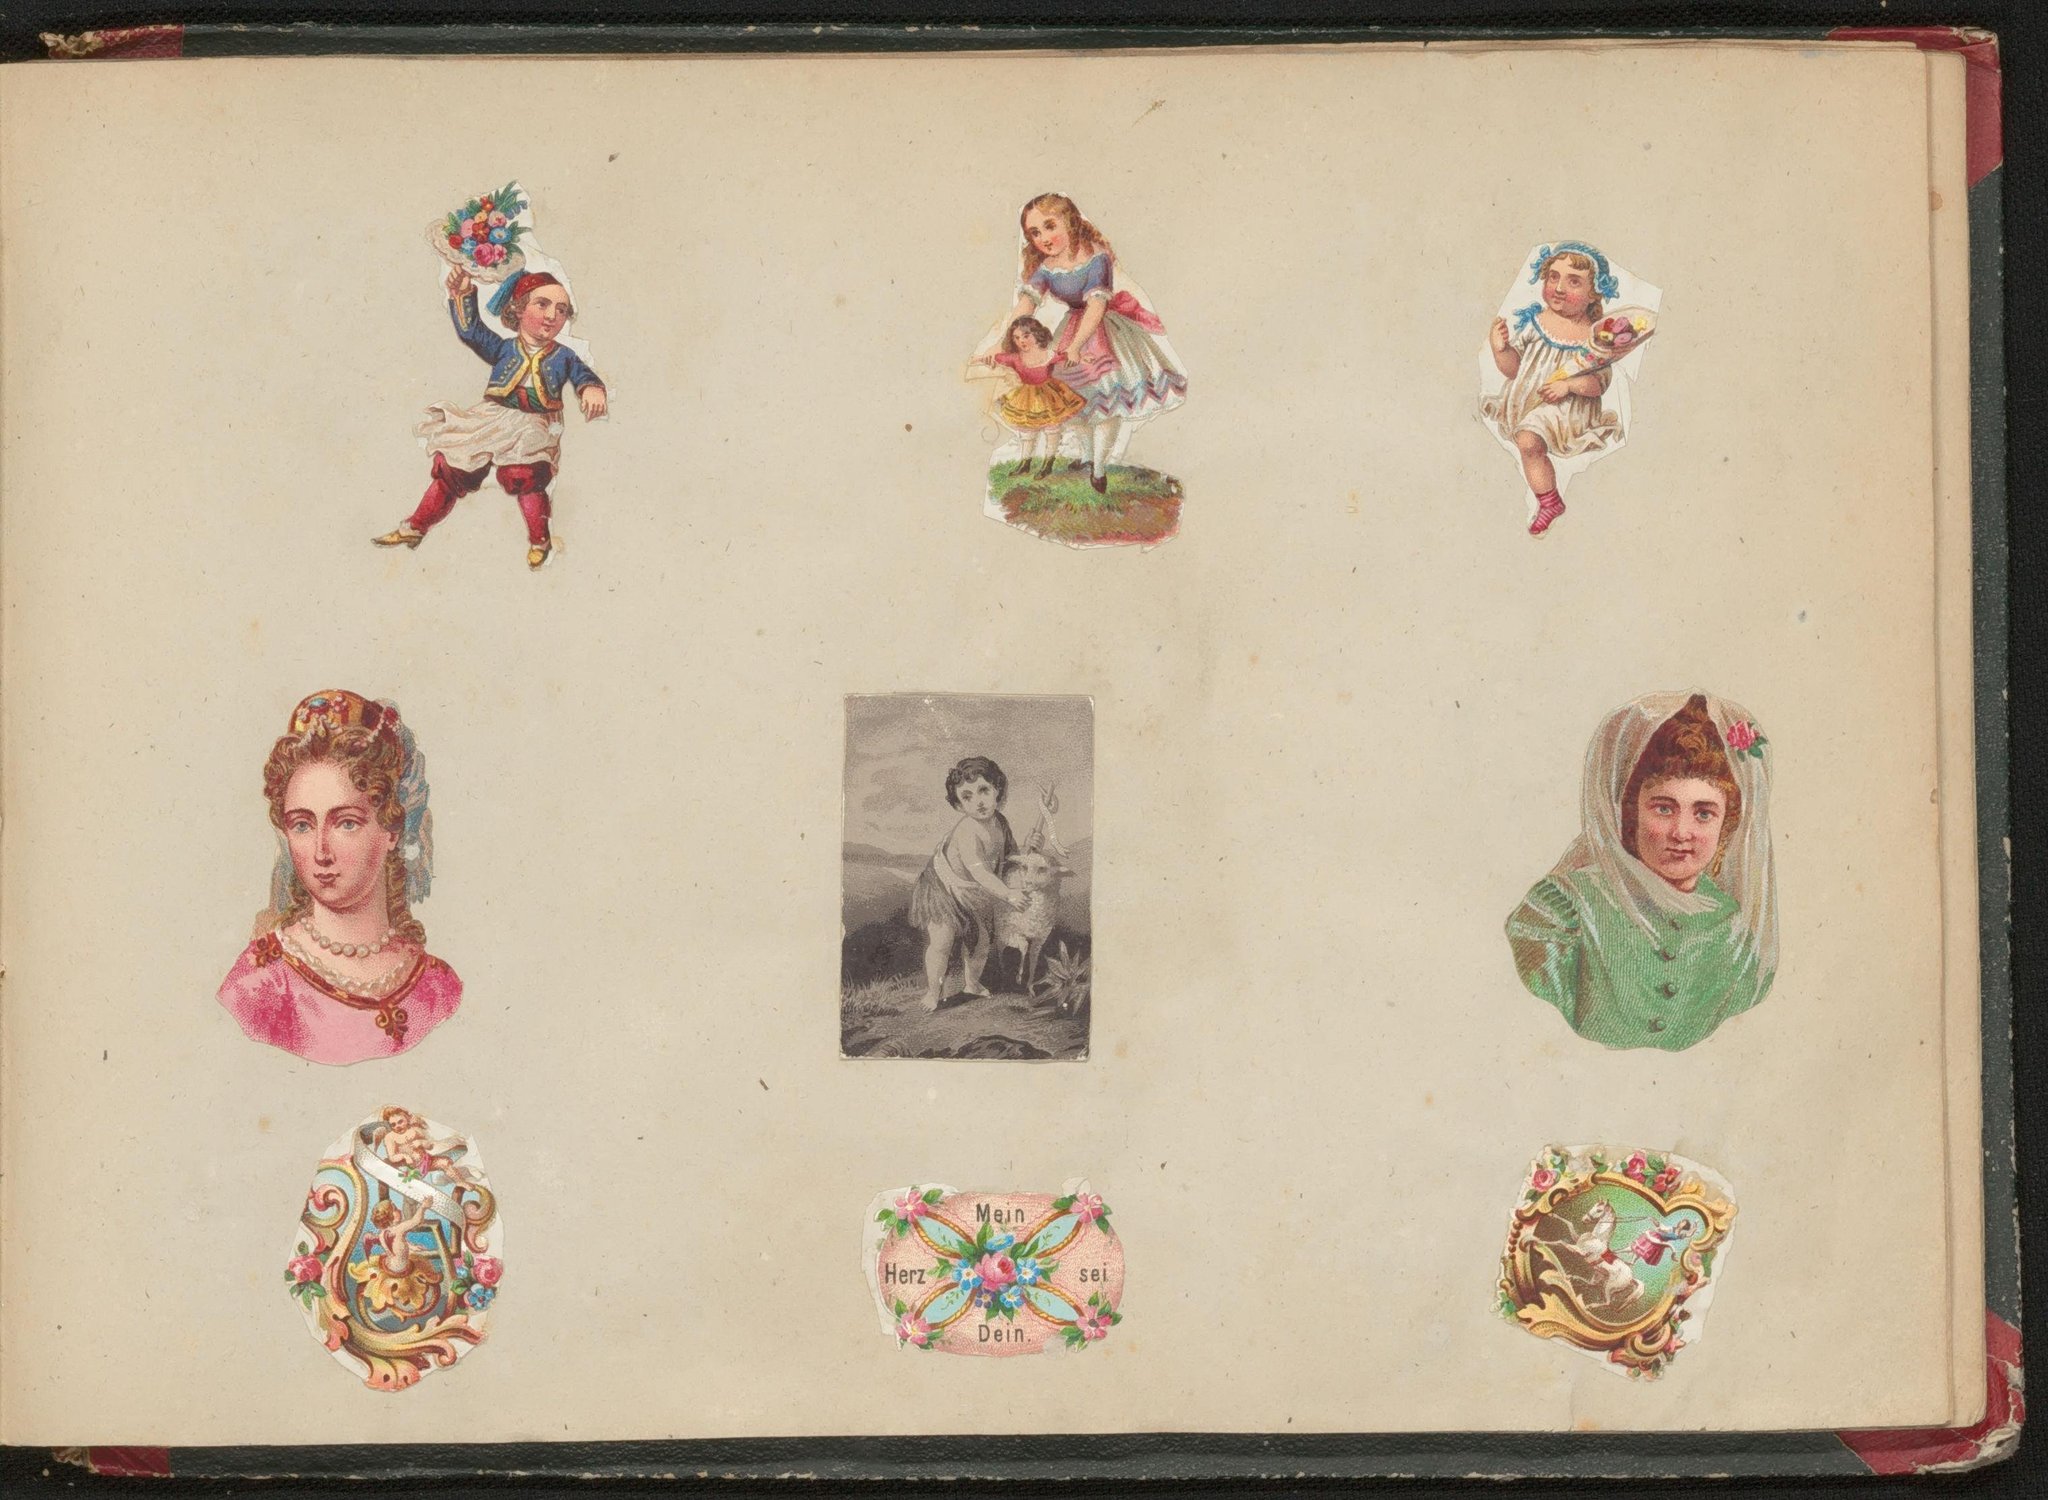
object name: album leaf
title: Albumblad met 9 plakplaatjes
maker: Anonymous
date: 1880-1910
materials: paper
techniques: chromolithography, lithograph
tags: ornaments ~ art, dancing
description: Albumblad met 9 plakplaatjes van cartouches, dansende figuren en vrouwenportretten, centraal het Christuskind met een lam. Onderdeel van het plakboek met 38 bladen gevuld met plakplaatjes, poesieplaatjes en uitgeknipte en ingeplakte fragmenten van prenten. Onderwerpsrubrieken binnen de Atlas Zeden en Gewoonten: Schoone kunsten, Varia.